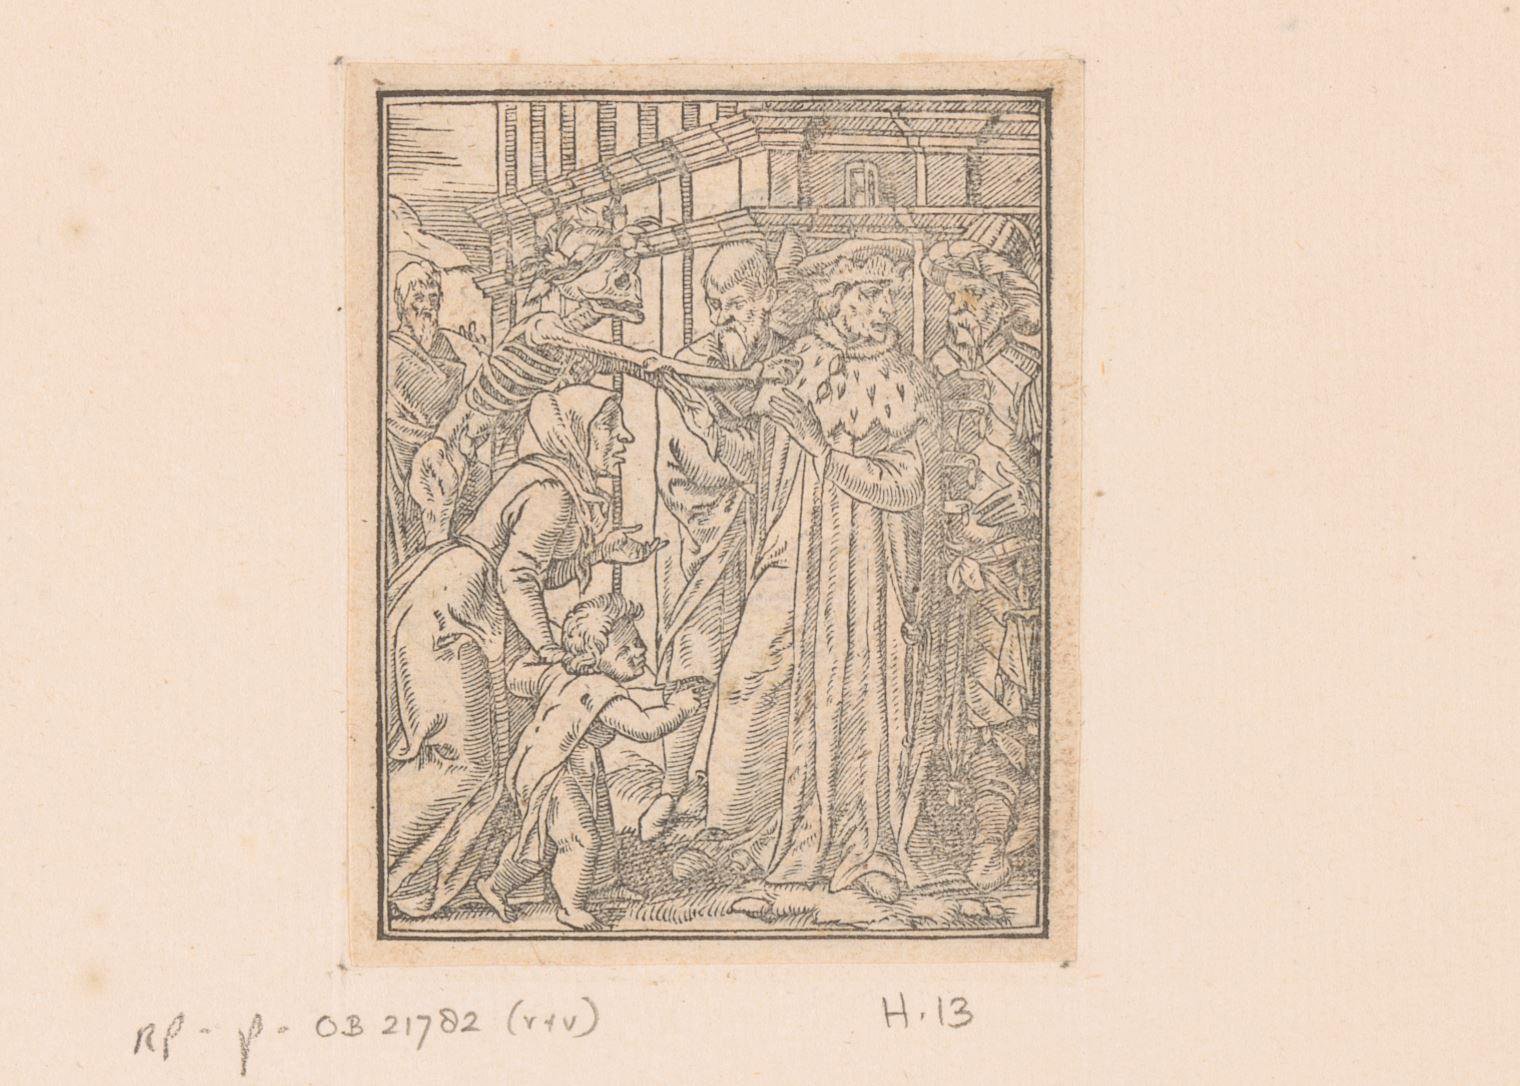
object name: print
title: Hertog en de Dood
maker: Anonymous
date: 1547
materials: paper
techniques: woodcut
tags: dance of death; death together with one or more human beings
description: Kopie van een prent van Hans Holbein de jongere uit 1538, voor het eerst gepubliceerd in: Imagines mortis (...). Lyon: Johannes Frellon, 1547.